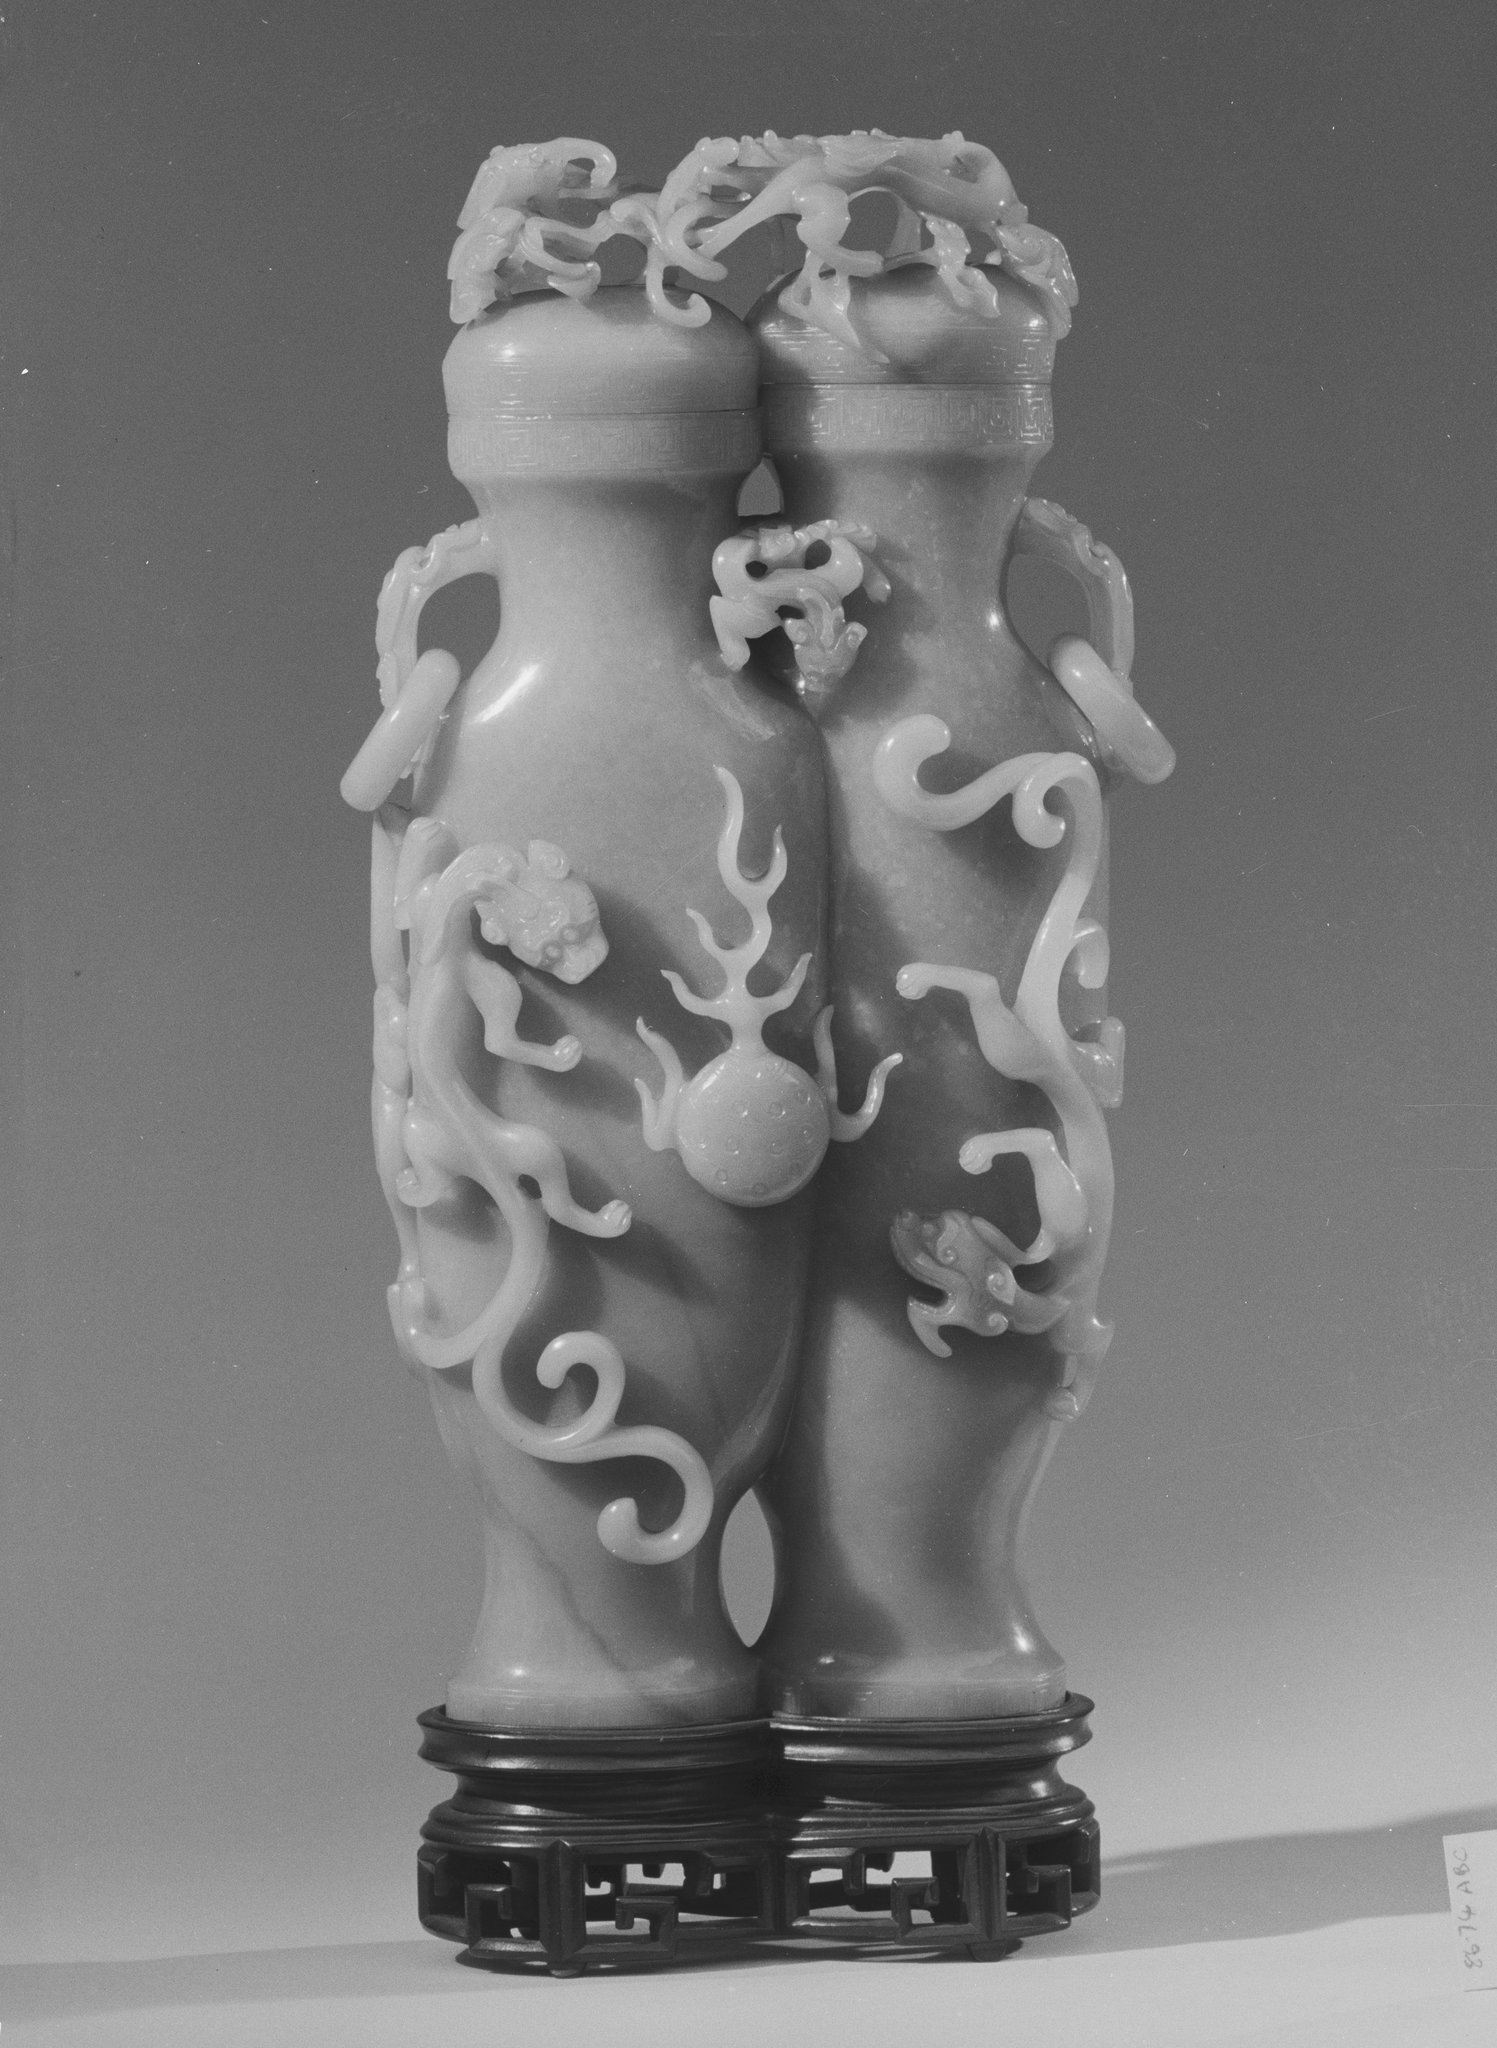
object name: double vase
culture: chinese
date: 1801-1833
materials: jade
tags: dragons